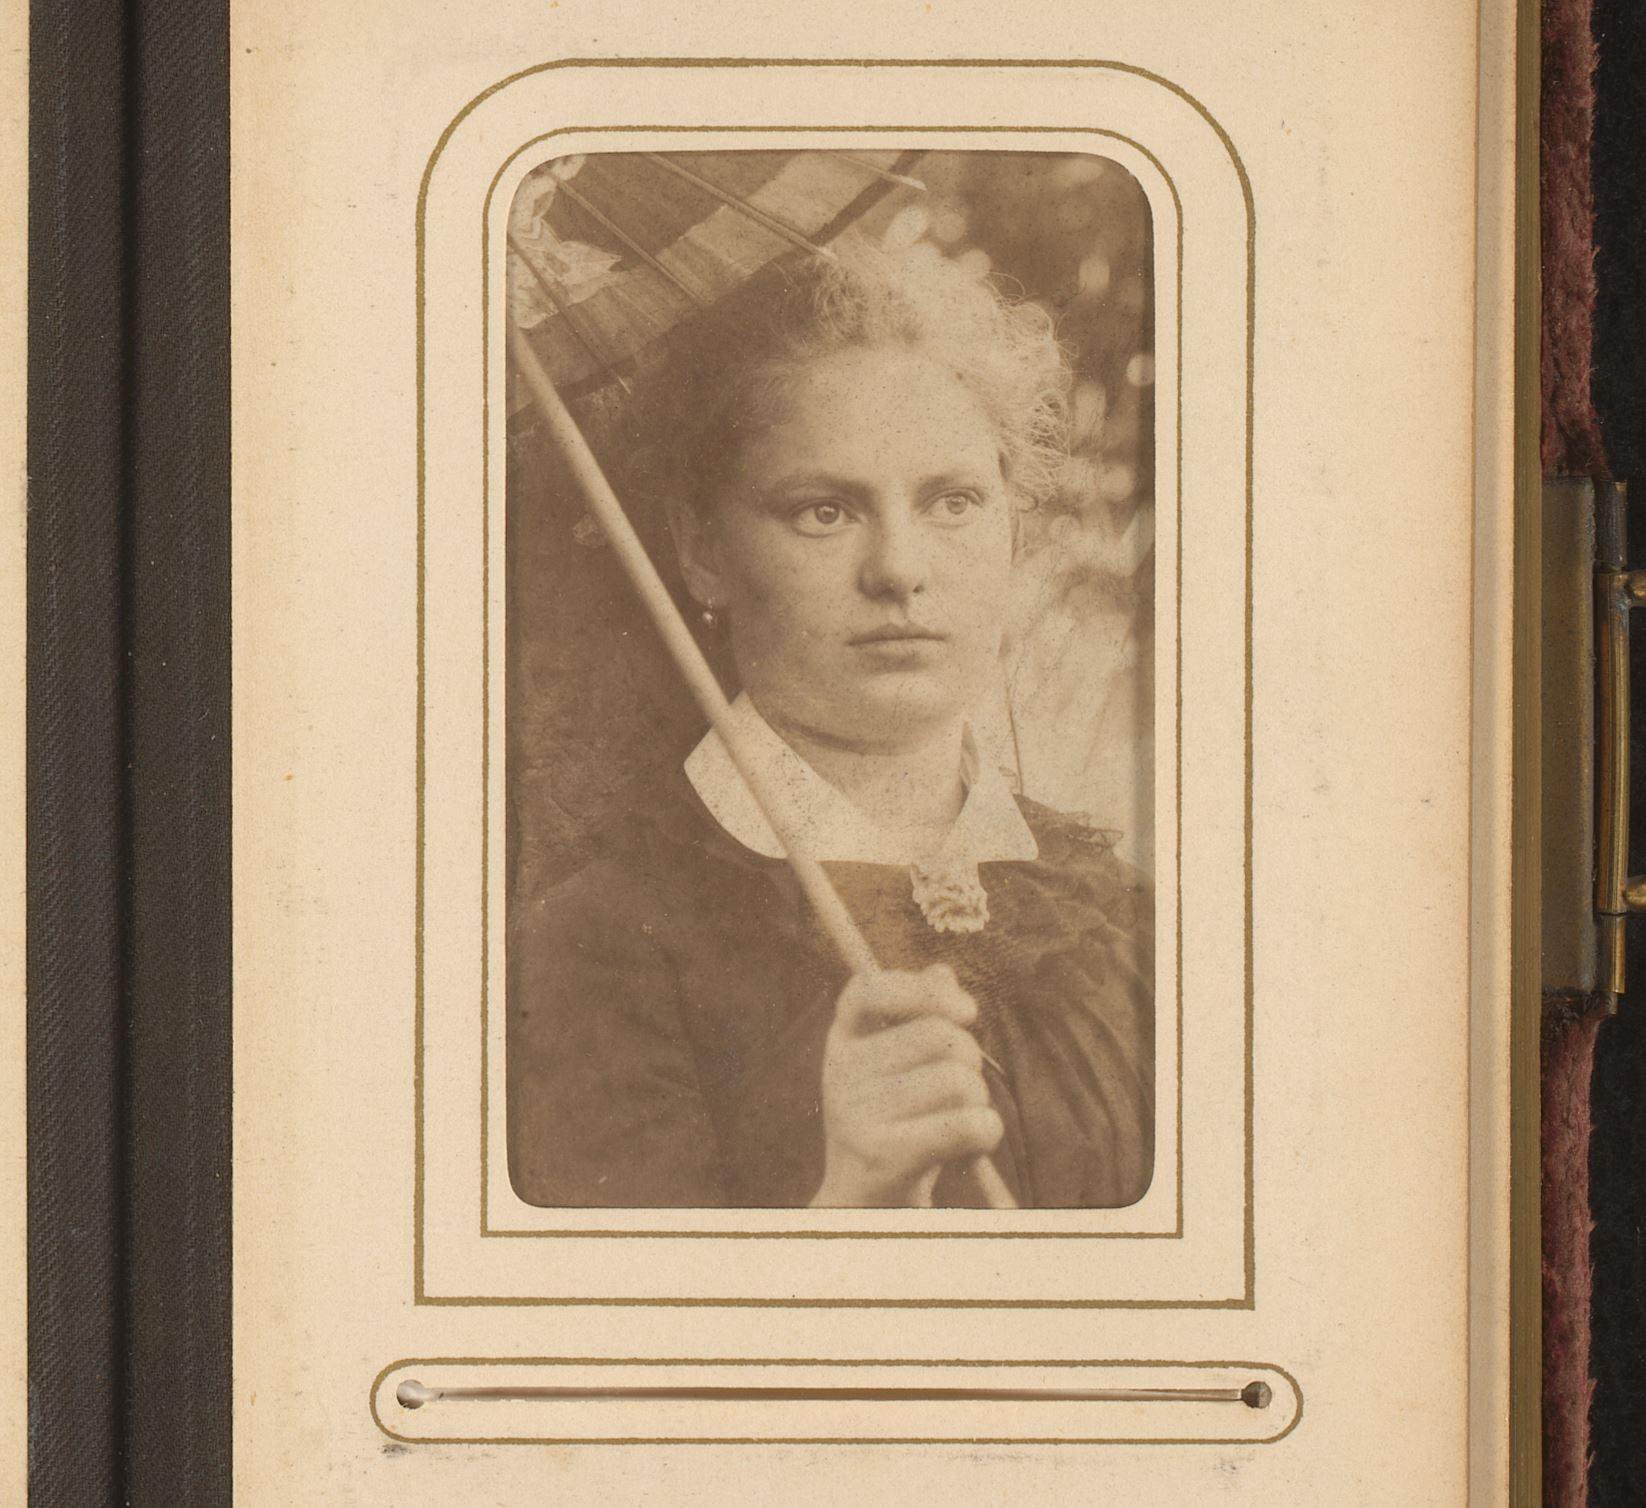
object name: album leaf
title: Portret van een vrouw met parasol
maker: Anonymous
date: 1860-1900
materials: cardboard, photographic support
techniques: albumen print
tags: adult woman, historical persons, parasol, sunshade